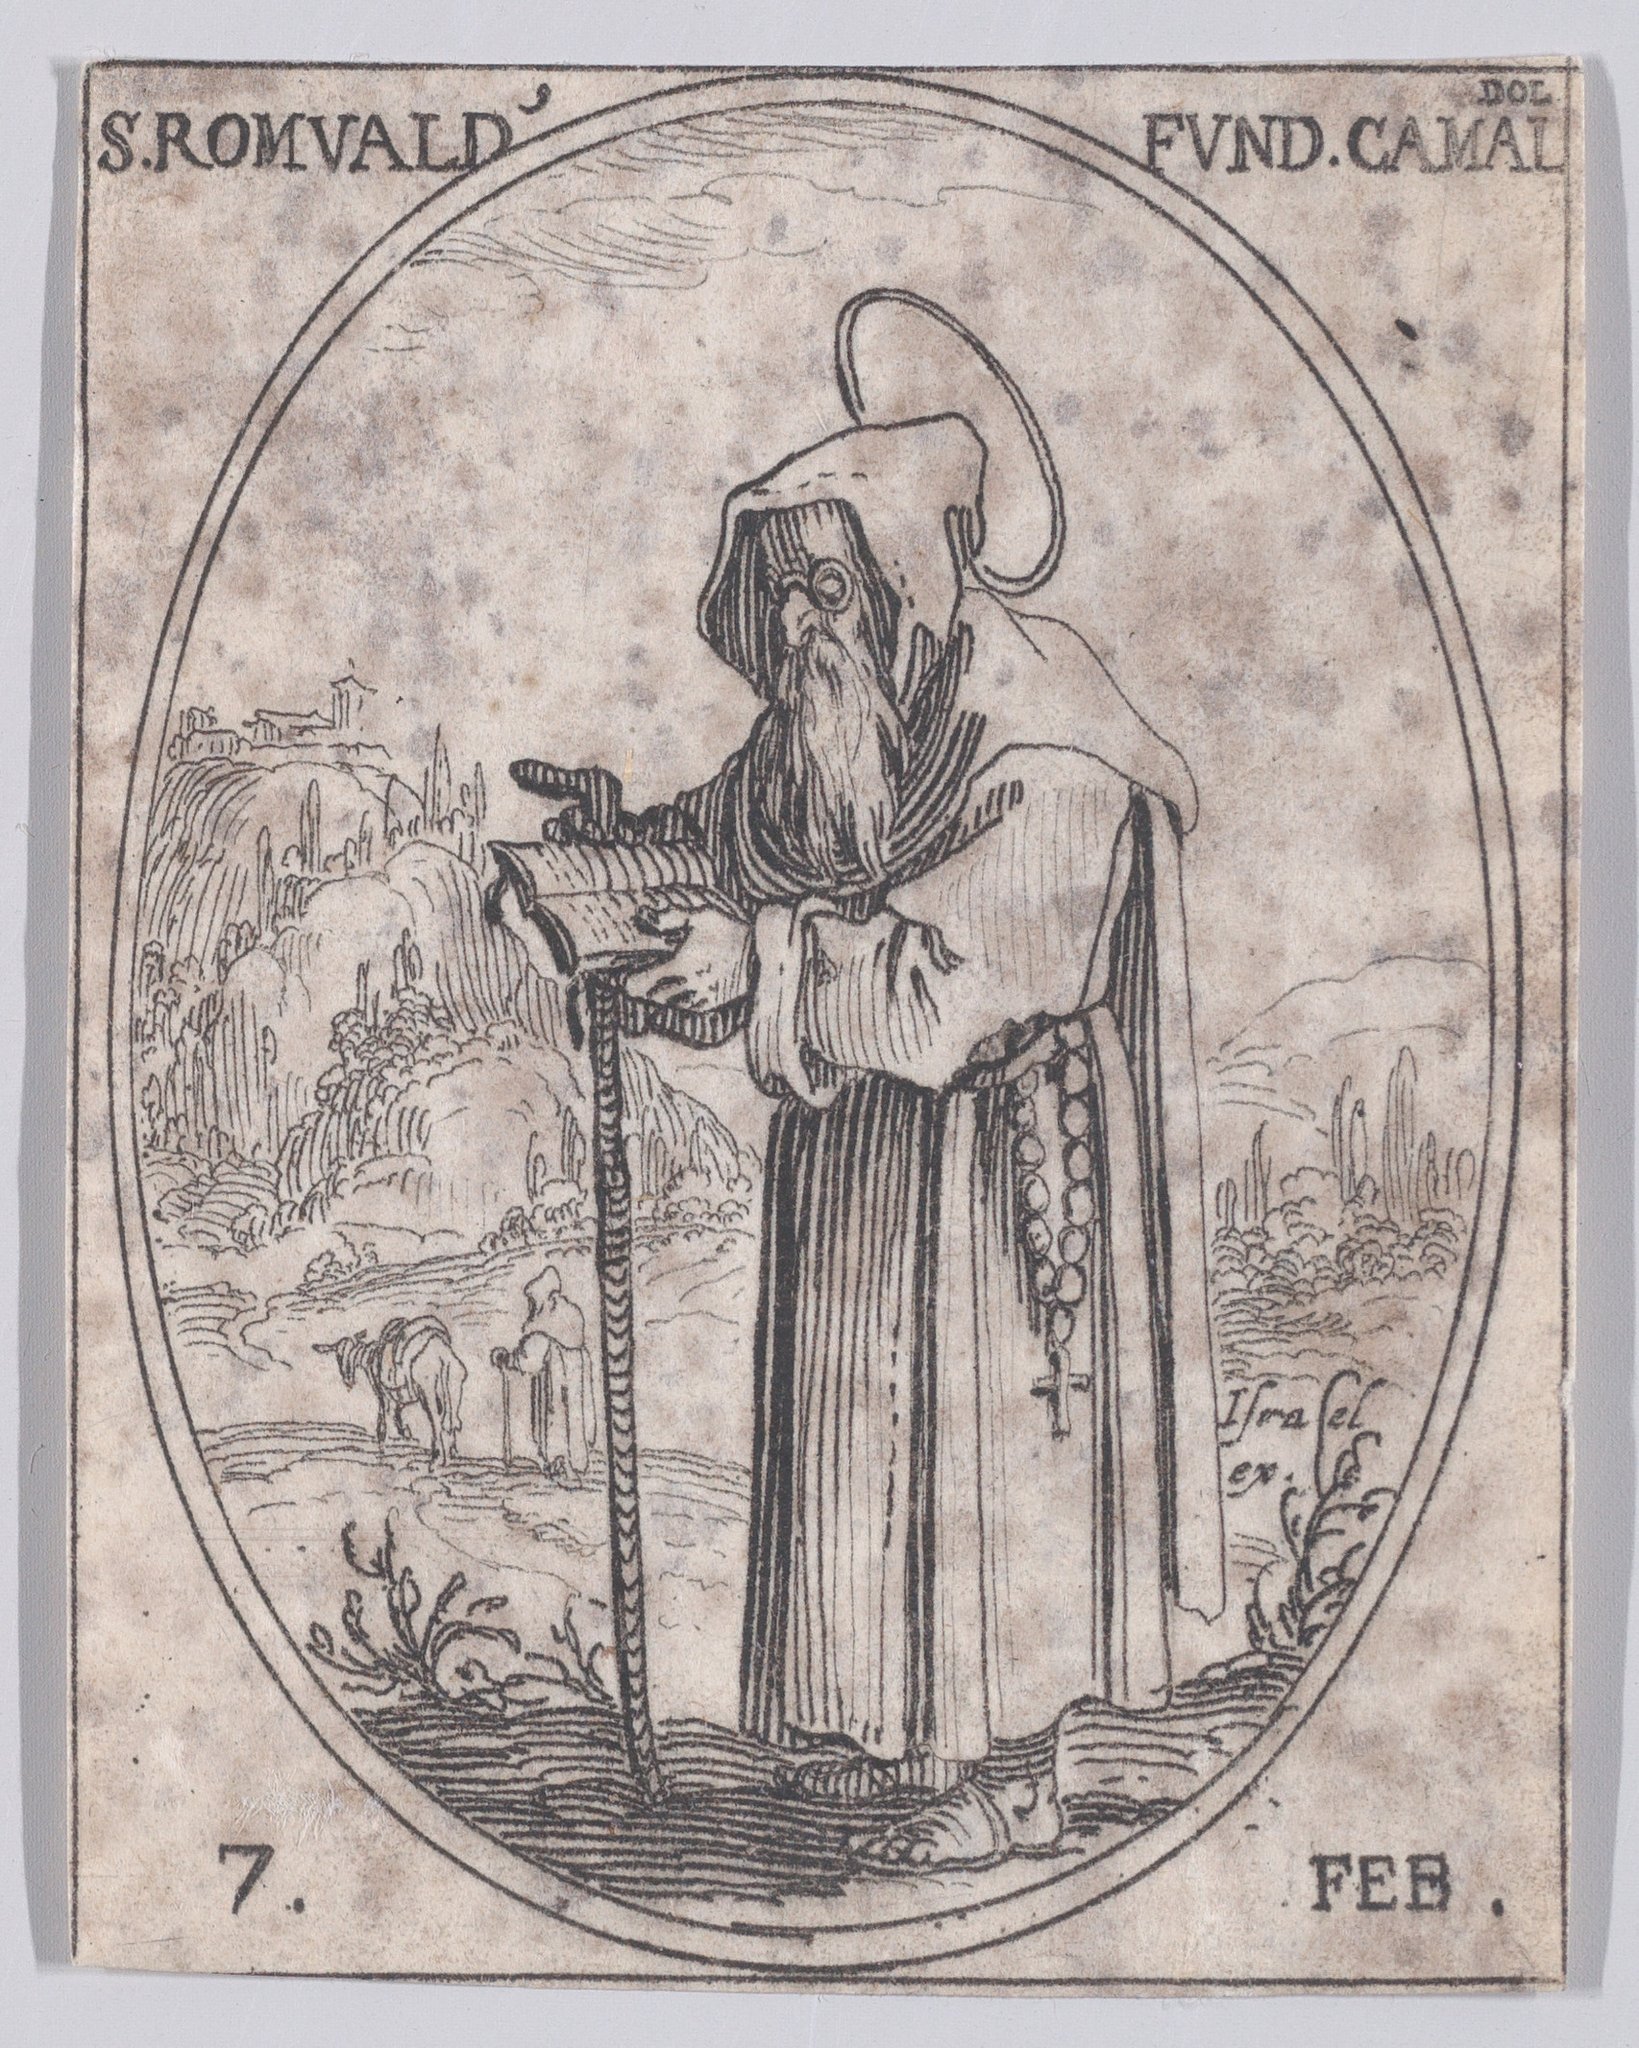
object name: print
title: S. Romuald, Fondateur des Camaldules (St. Romuald, Founder of the Camaldolese Order), February 7th, from "Les Images De Tous Les Saincts et Saintes de L'Année" (Images of All of the Saints and Feast Days of the Year)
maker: jacques callot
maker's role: artist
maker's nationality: french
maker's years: 1592-1635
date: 1636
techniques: etching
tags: men,saints